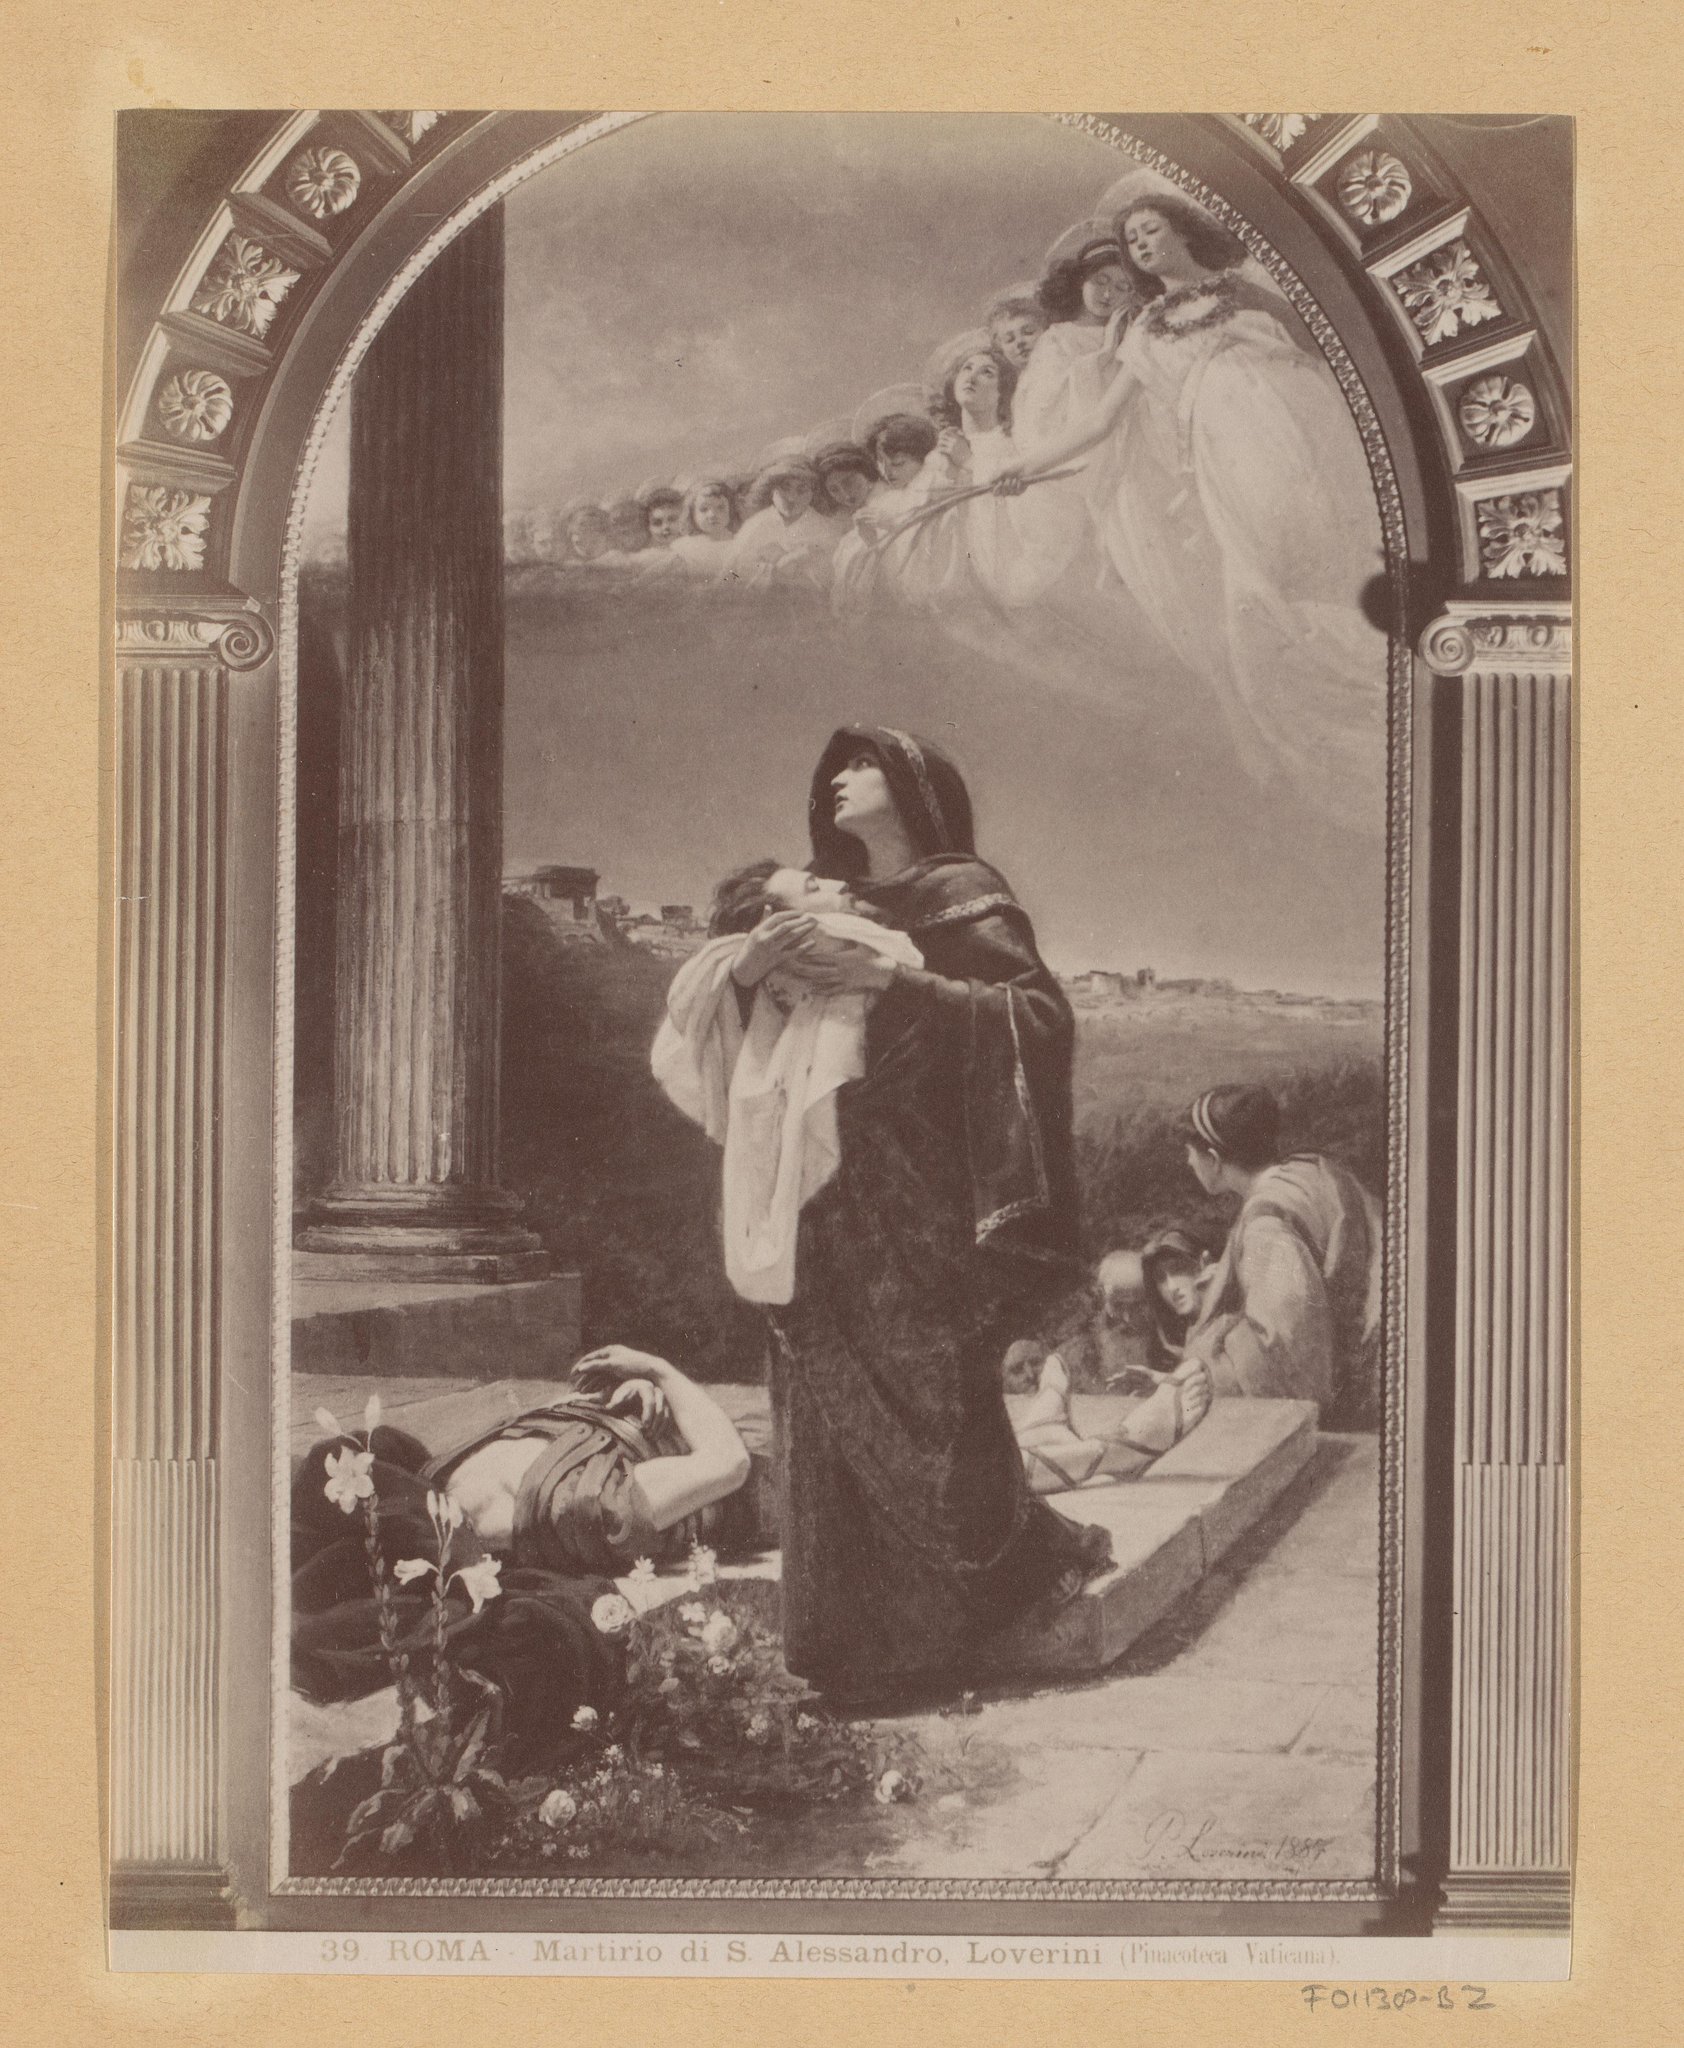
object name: photograph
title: Fotoreproductie van een schilderij door Ponziano Loverini, voorstellend het martelaarschap van de H. Alexander van Bergamo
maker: Anonymous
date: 1887-1900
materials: photographic support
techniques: albumen print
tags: death penalty, execution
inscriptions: number: ‘39’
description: Onderdeel van Reisalbum met opnames van kunstwerken en bezienswaardigheden in Italië, Griekenland en Frankrijk.